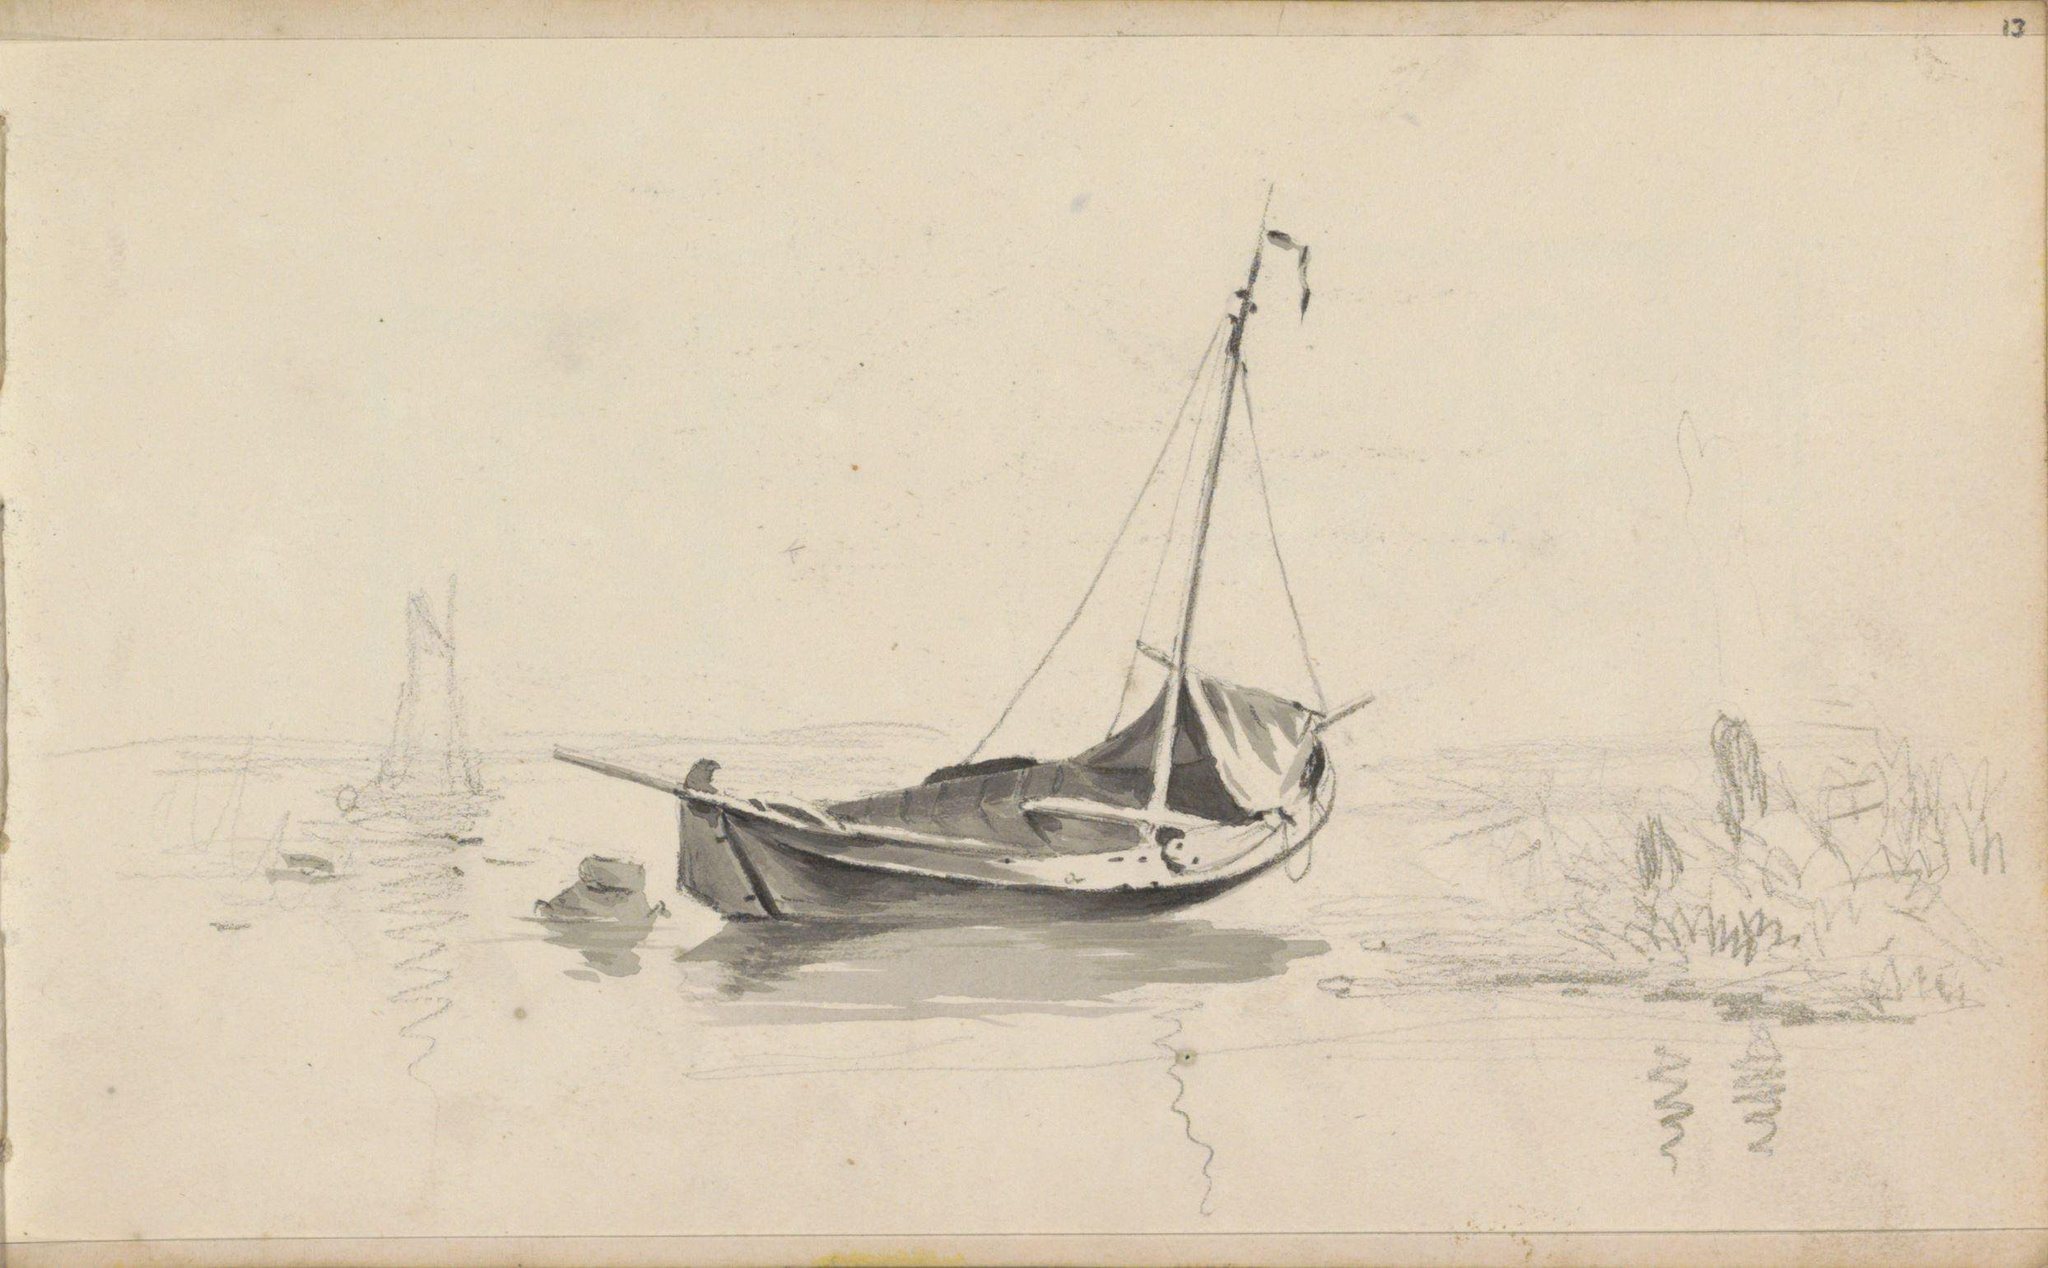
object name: sketchbook leaf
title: Twee zeilschepen op open water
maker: adrianus eversen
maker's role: draughtsman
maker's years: 1818-1897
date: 1828-1897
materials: paper, pencil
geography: netherlands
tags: sailing-ship, sailing-boat, landscapes with waters, waterscapes, seascapes (in the temperate zone)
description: Vooraan ligt een zeilschip. In de mast hangt een vlag. Linksachter ligt een tweede zeilschip. Blad 13 uit een schetsboek met 27 bladen.